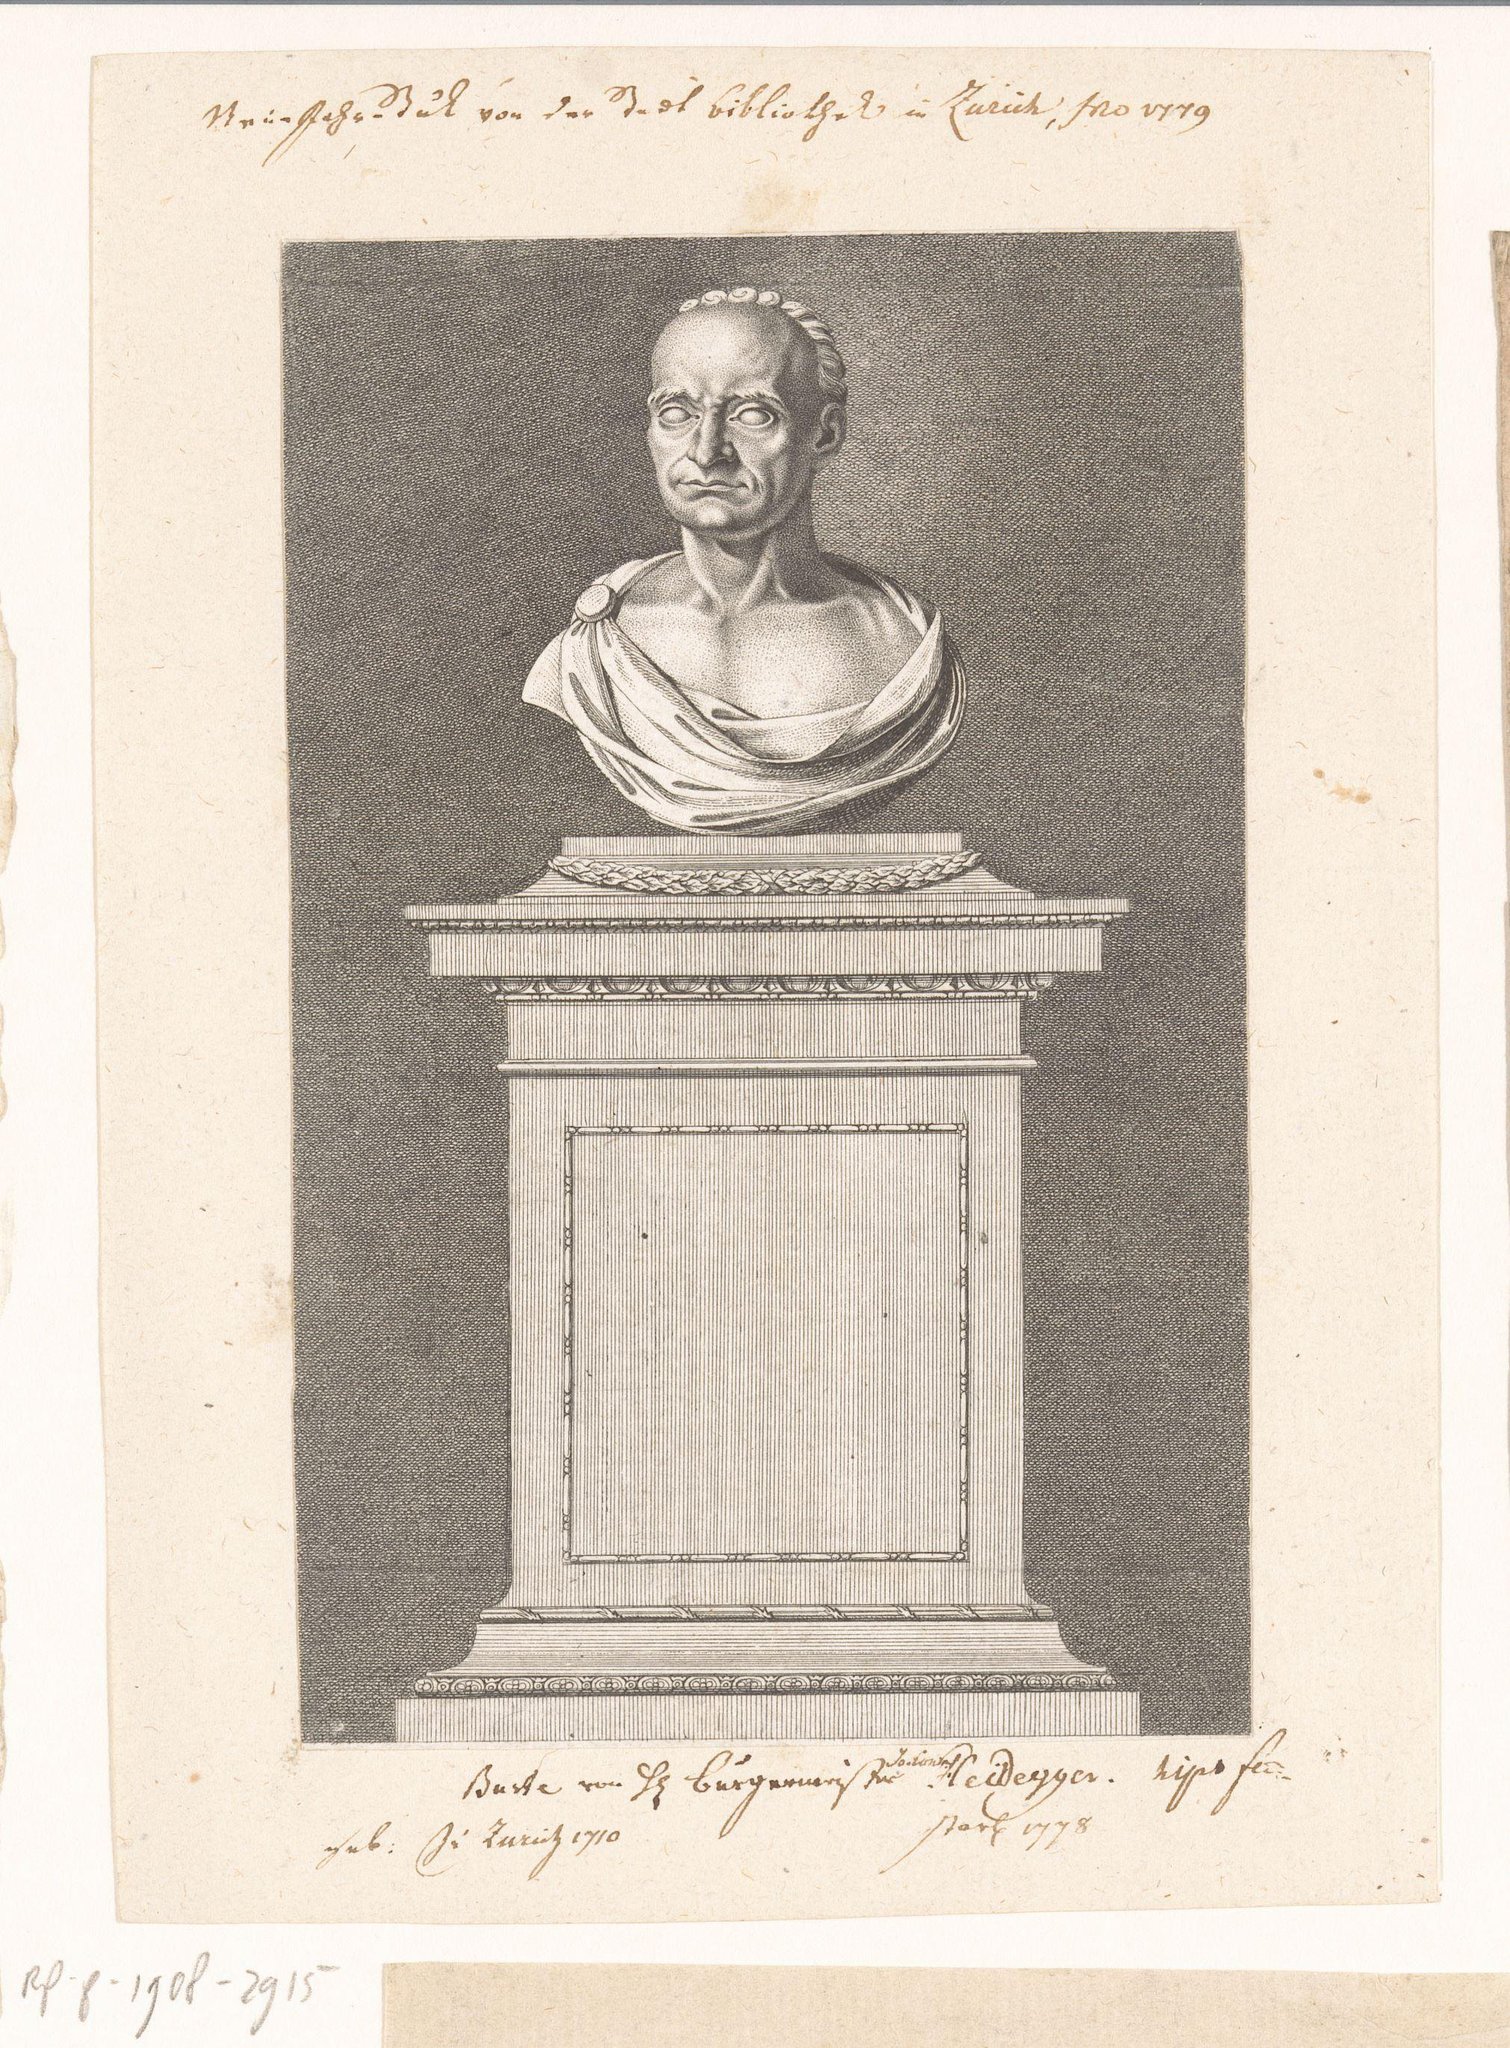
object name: print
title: Buste van Johann Heinrich Heidegger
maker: johann heinrich lips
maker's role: draughtsman, painter, print maker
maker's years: 1758-1817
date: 1768-1817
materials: paper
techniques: engraving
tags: switzerland, historical persons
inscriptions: collector's mark: Lugt 2228